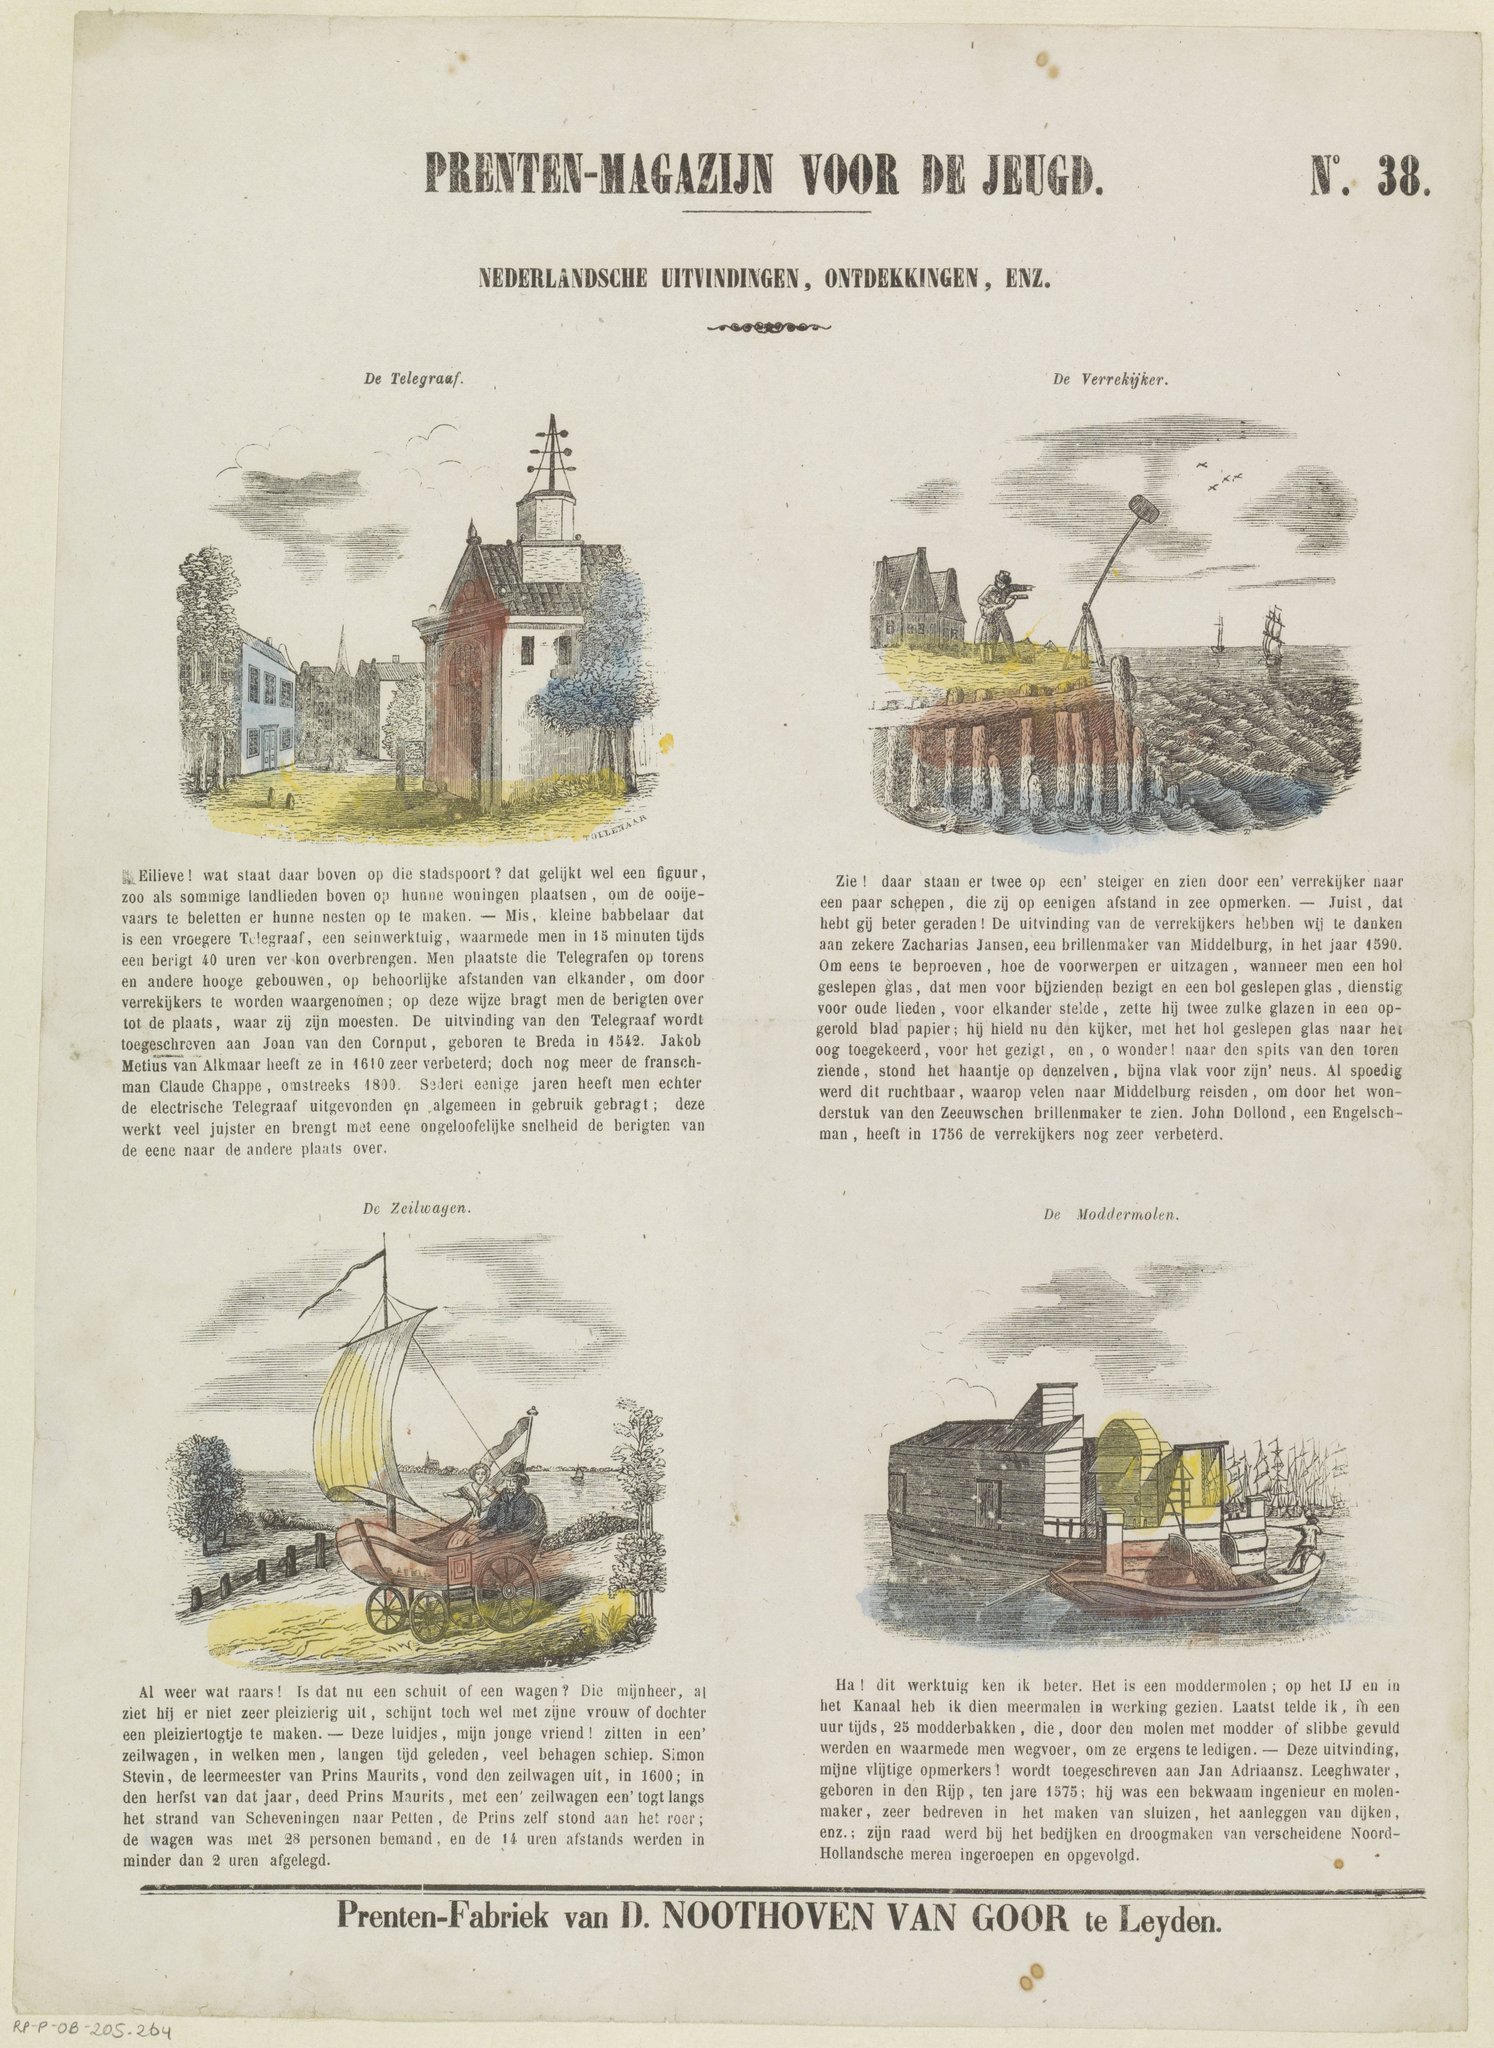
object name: popular print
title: Nederlandsche uitvindingen, ontdekkingen enz.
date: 1850-1881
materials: paper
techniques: colour, letterpress printing, engraving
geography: leiden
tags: (morse) telegraph, sailing-ship, sailing-boat (+ traffic on land), dredge, dredging machine, invention, discovery ~ science and technology, binoculars, spy-glass, etc.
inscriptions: collector's mark: Lugt 2760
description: Blad met 4 voorstellingen van Nederlandse uitvindingen en ontdekkingen: de telegraaf, de verrekijker, de zeilwagen en de moddermolen. Boven elke voorstelling een titel en onder elke voorstelling een onderschrift. Genummerd rechtsboven: No. 38.